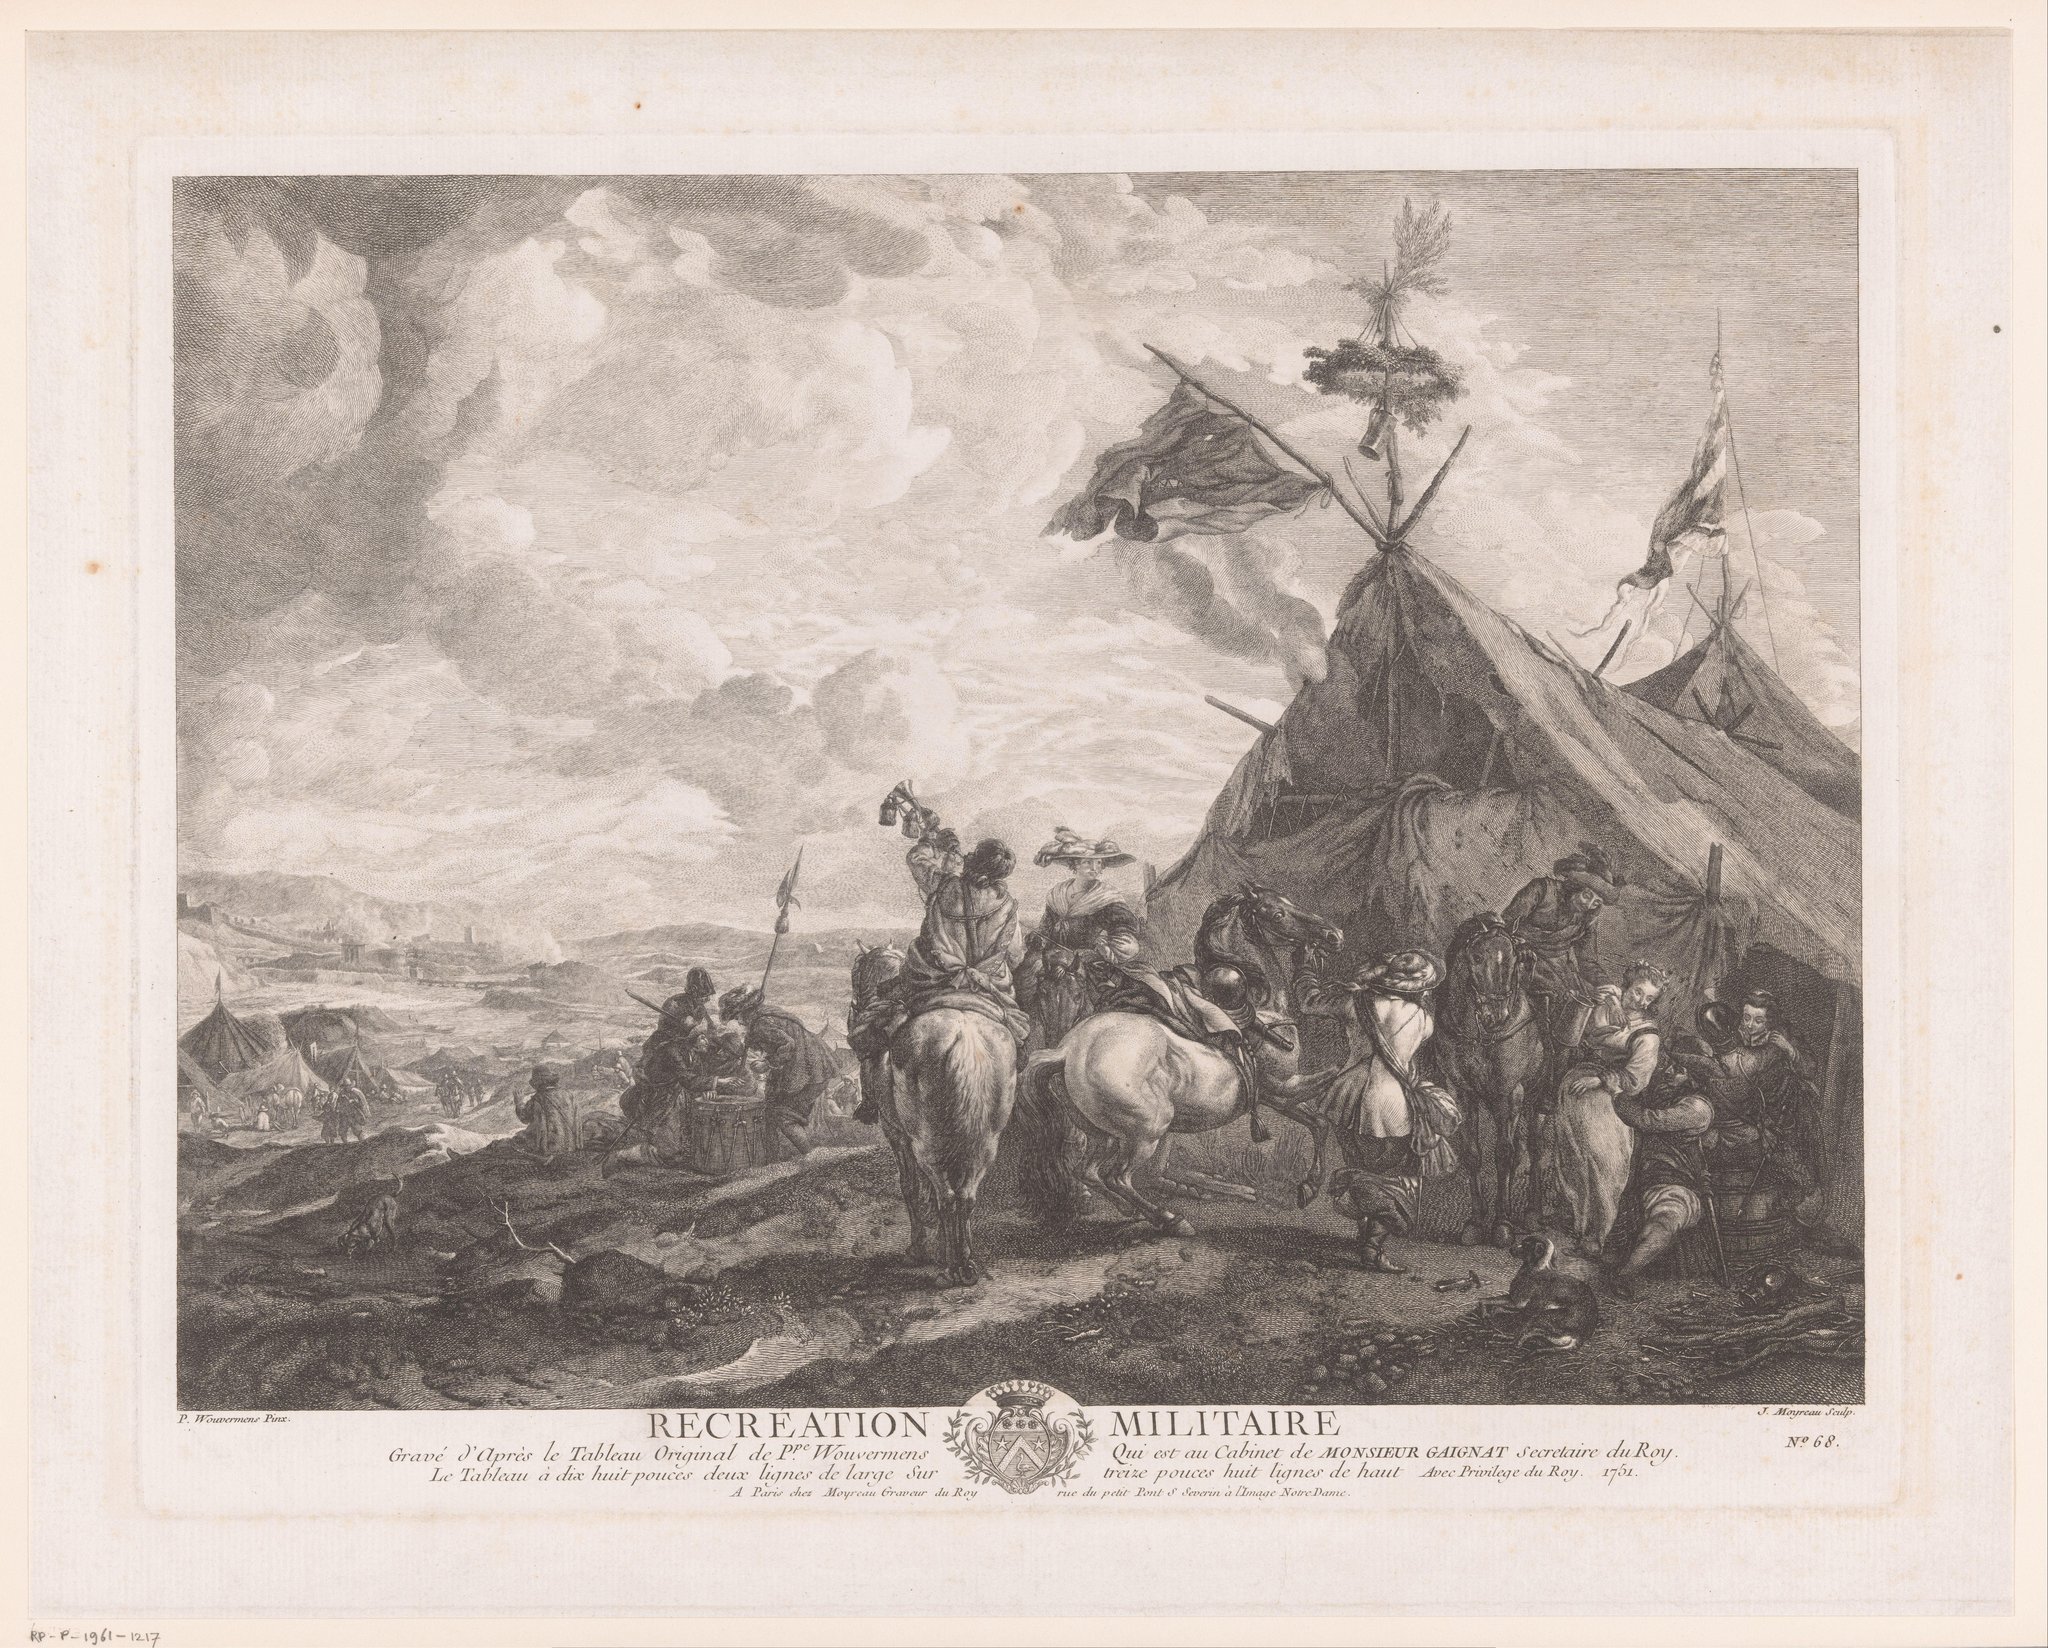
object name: print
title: Récréation militaire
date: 1751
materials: paper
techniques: engraving, etching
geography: paris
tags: riding a horse, ass, or mule; rider, horseman, (military) camp with tents, tent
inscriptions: collector's mark: Lugt 2228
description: Maakt deel uit van een serie van 89 prenten te dateren tussen ca. 1733-1762, naar het geschilderde oeuvre van Philips Wouwerman.